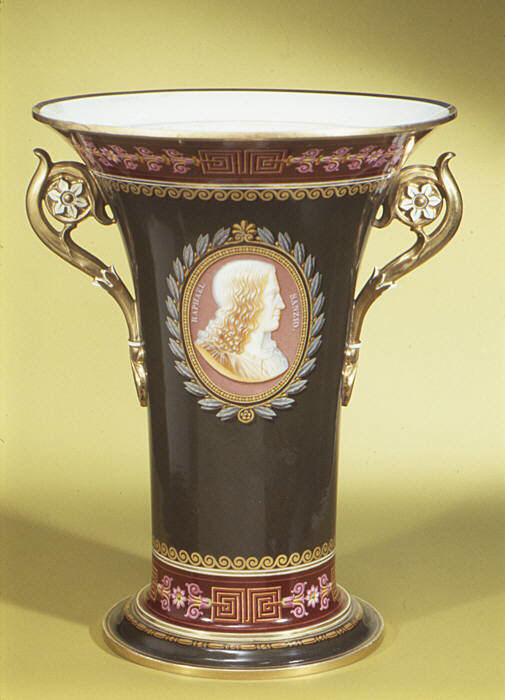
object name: vase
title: Vase (jasmin japonais)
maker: sèvres manufactory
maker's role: manufactory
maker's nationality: french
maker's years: 1740-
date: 1834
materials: hard paste porcelain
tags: men,profiles